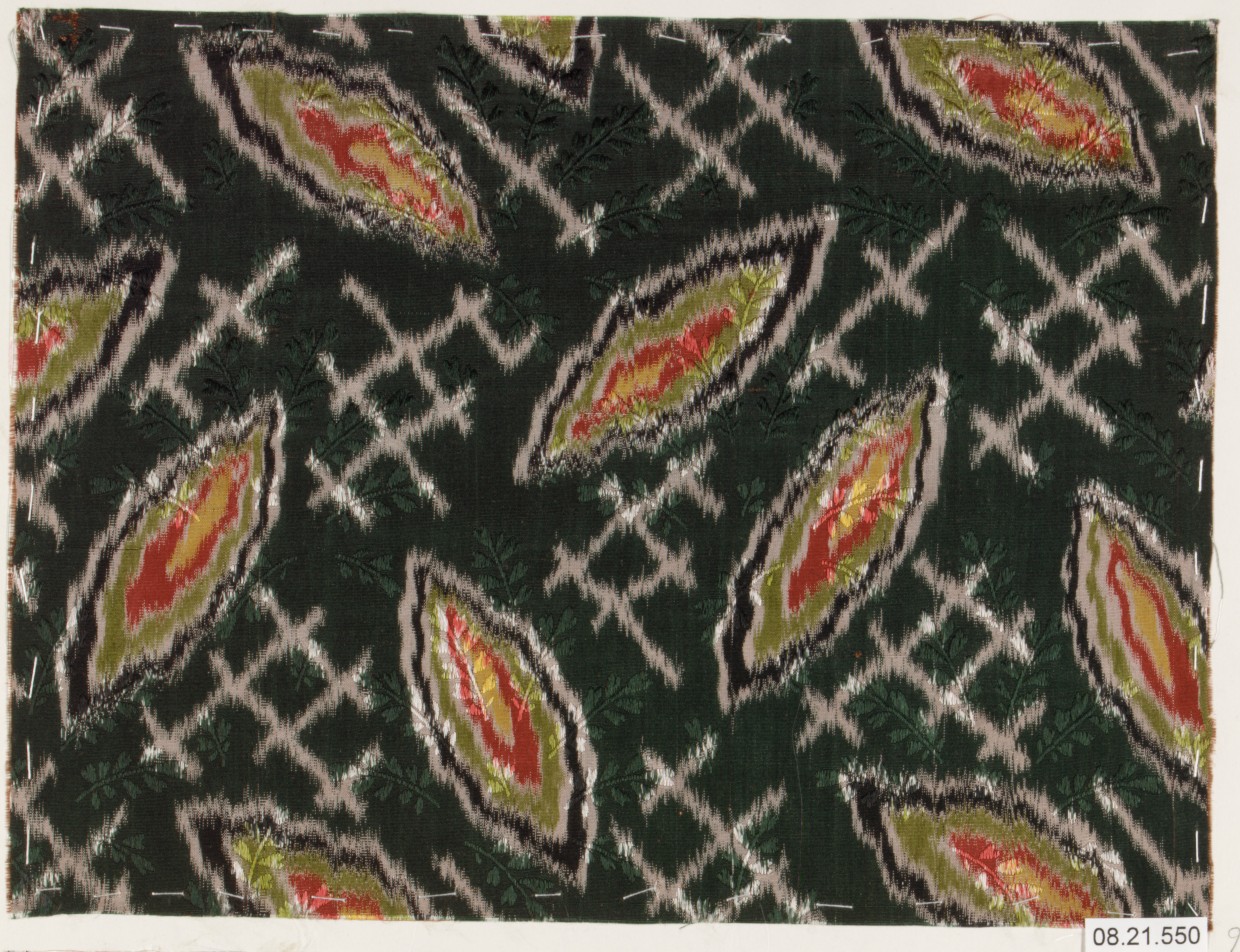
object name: textile sample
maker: Anonymous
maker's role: designer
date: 1900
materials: silk